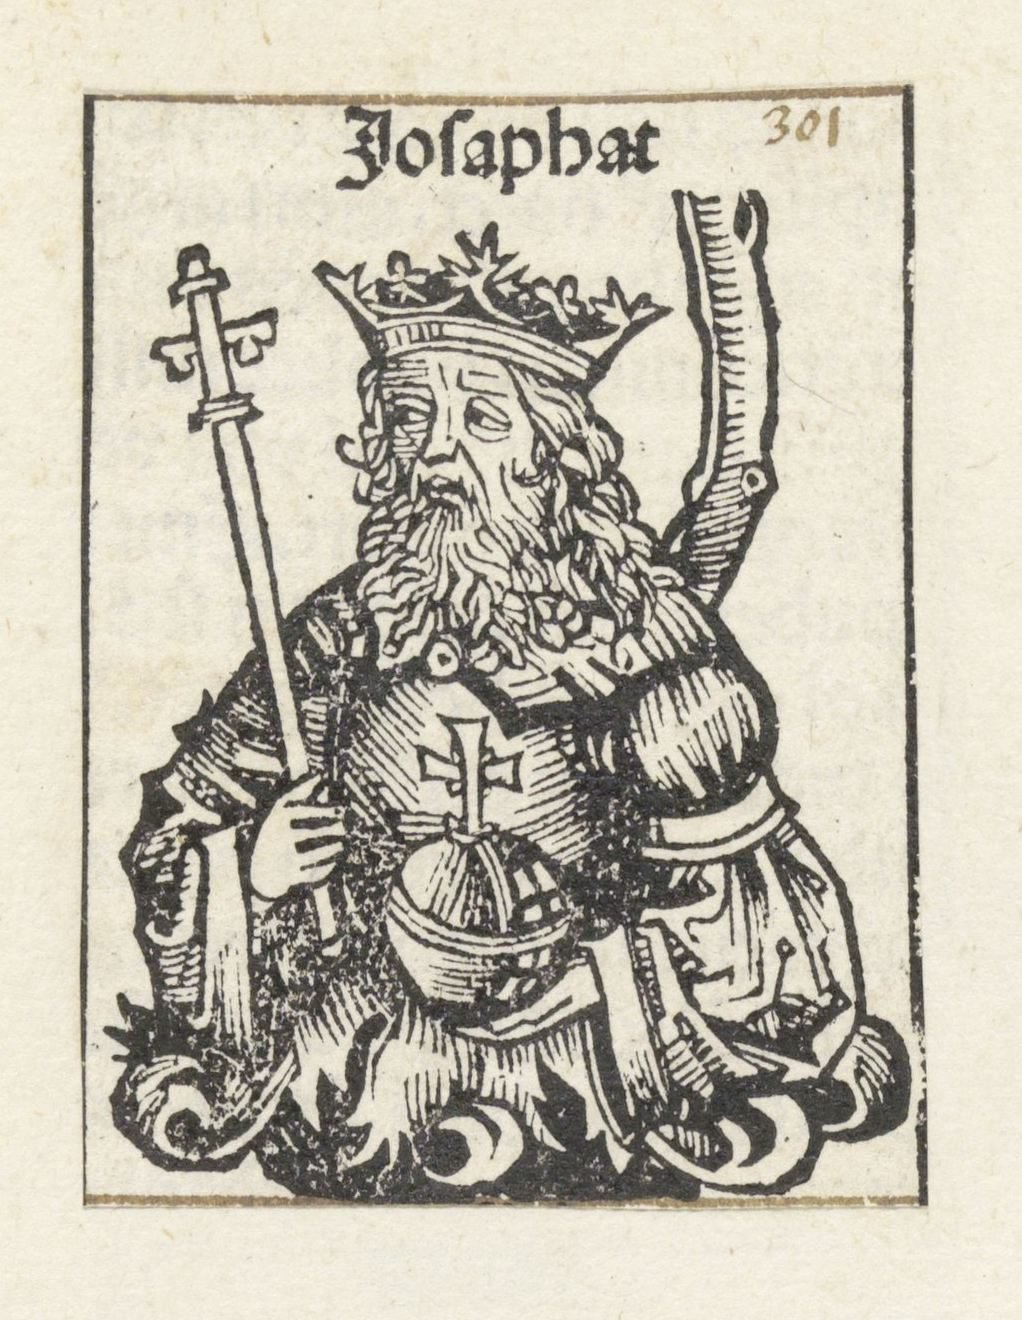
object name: book illustration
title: Josafat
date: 1493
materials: paper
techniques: letterpress printing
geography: nuremberg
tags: king, persons from the old testament (not in biblical context, nor occurring in legendary/historical extensions included in division 71)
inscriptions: inscription: ‘301’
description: Een bloemkelk met een koning, naar links gekeerd. De man heeft een scepter en rijksappel in zijn handen. De tekst identificeert hem als Josafat, koning van Juda. De voorstelling is onderdeel van de stamboom van Christus in de Liber Chronicarum. De prent maakt deel uit van een album.